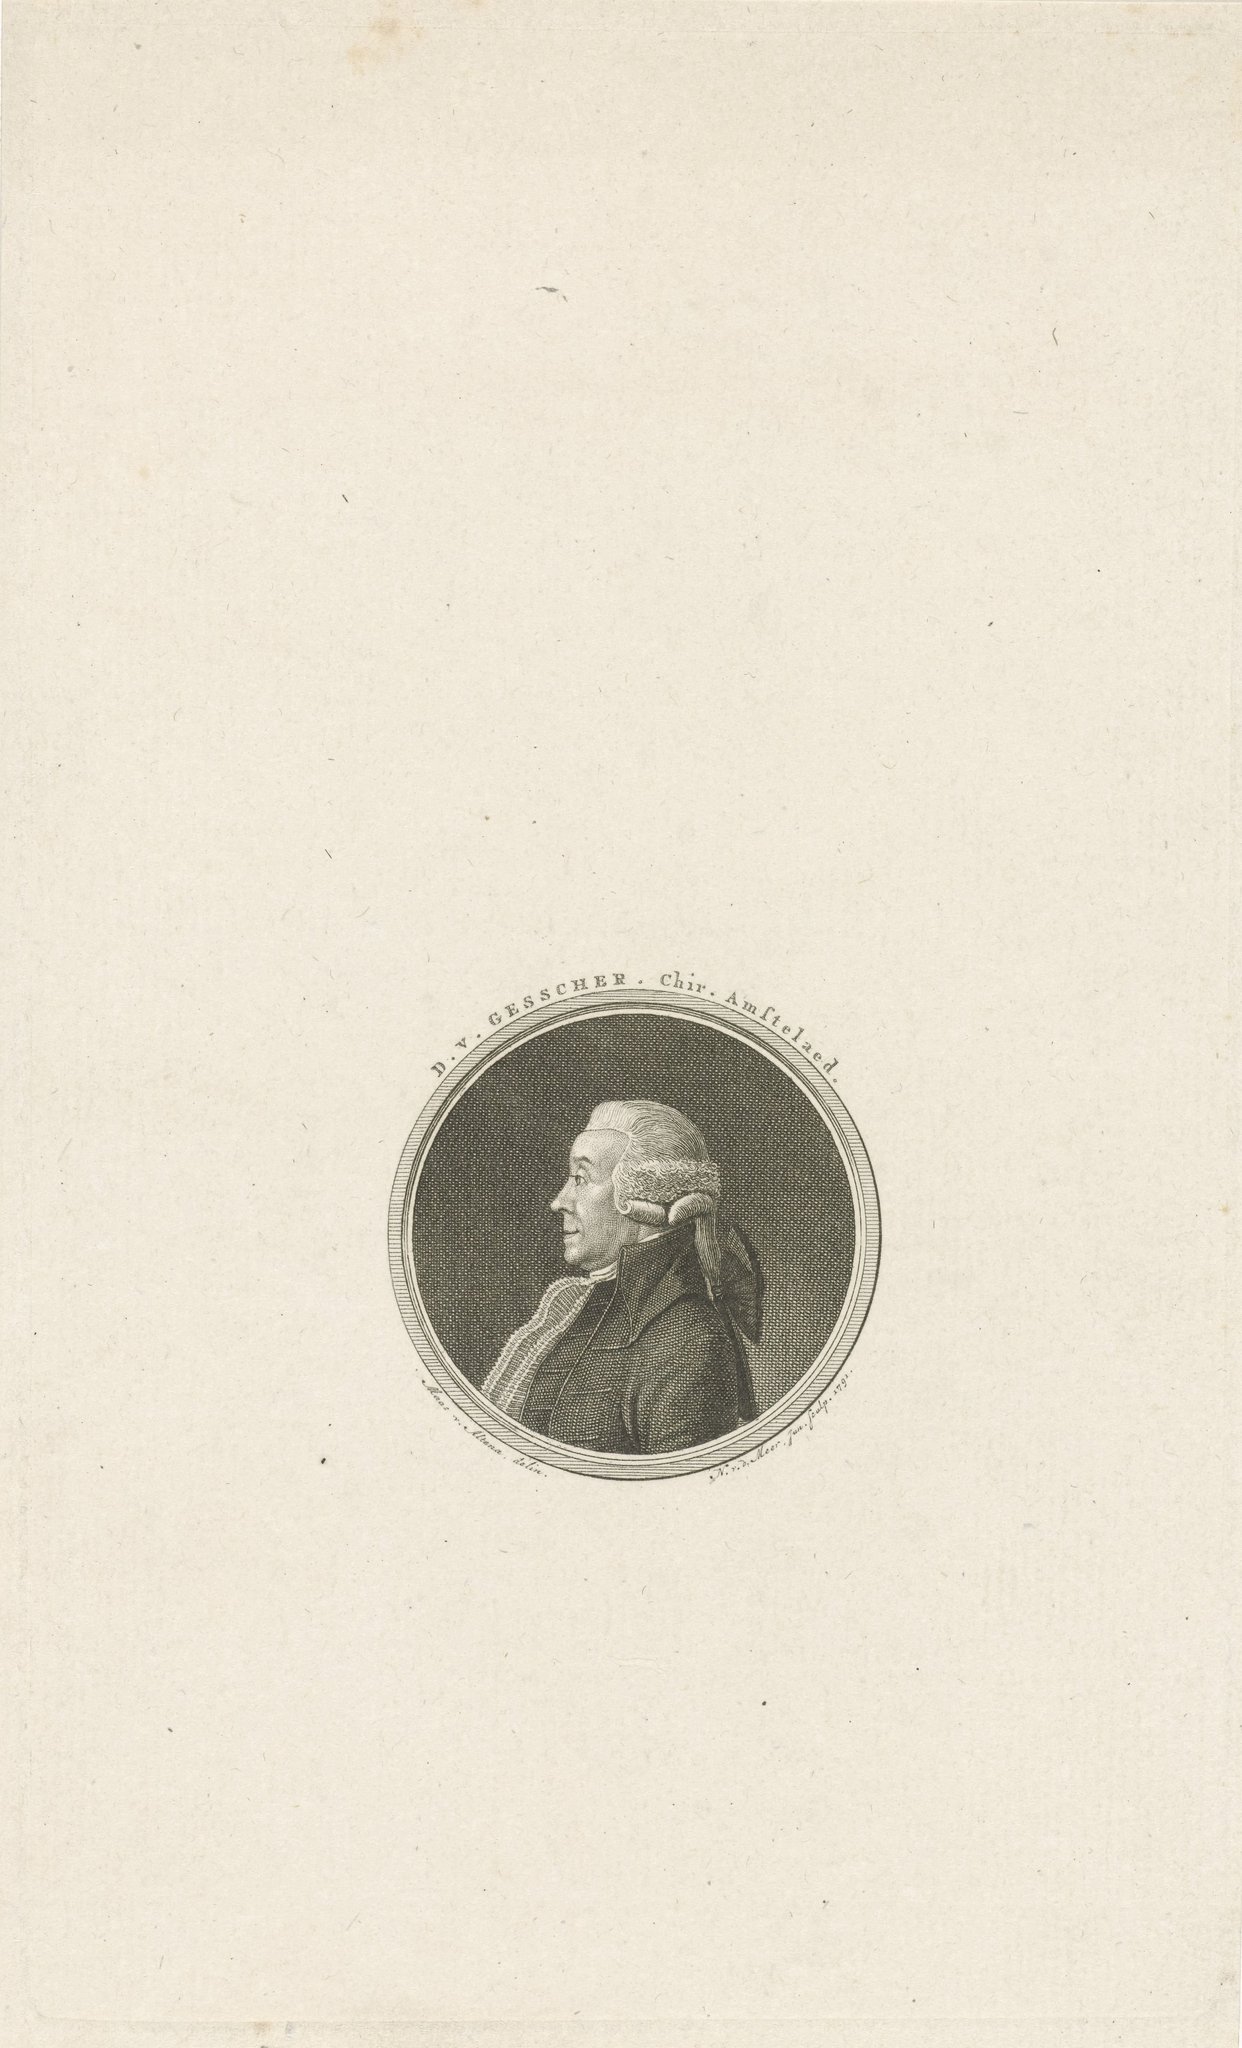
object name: print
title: Portret van David van Gesscher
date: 1791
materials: paper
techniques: etching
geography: amsterdam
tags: chirurg, david van gesscher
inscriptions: collector's mark: Lugt 2228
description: Latere staat van prent gebruikt als titelpagina voor: Gesscher, David van. Heelkunde van Hippocrates. Amsterdam: Jan Barend Elwe, 1791, dl. 1.